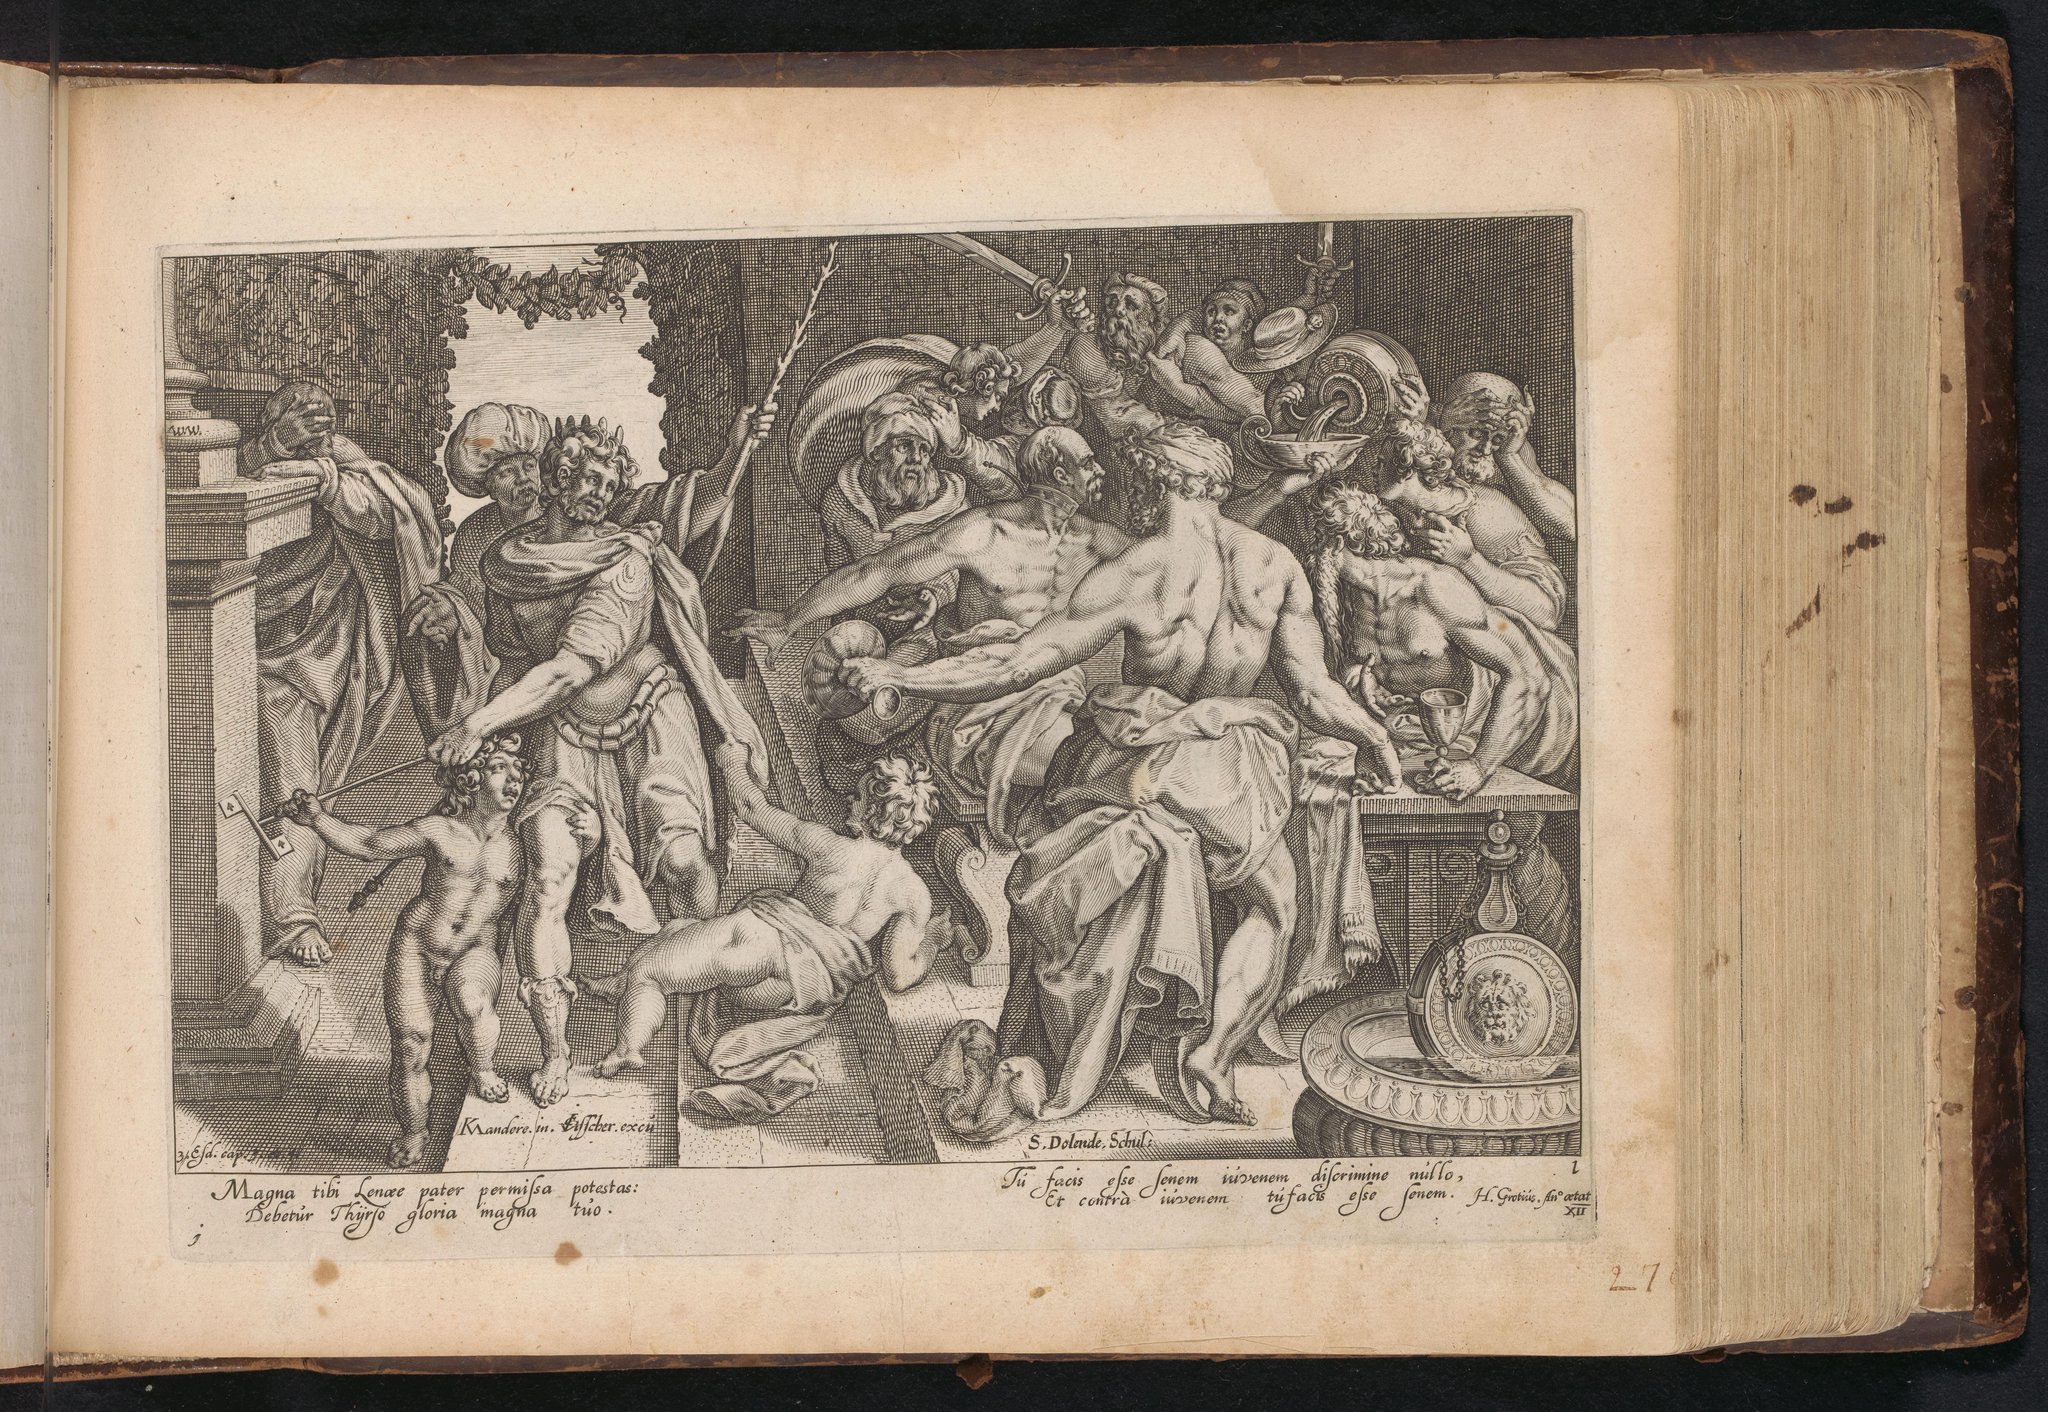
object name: album leaf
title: Scènes uit het apocriefe Bijbelboek 3 Esdras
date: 1595-1596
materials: paper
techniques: engraving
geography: amsterdam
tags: the books of ezra, nehemiah, and esdras, wine ~ alcoholic drinks, king, the first guardsman says (writes) that wine is the strongest of all things ~ contest of the three guardsmen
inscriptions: number: ‘27[6]’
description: De wijn als heerser over de wereld. Rond een tafel drinken mannen wijn. Ook een koning, links, staat onder invloed van wijn. Rondom hem dronken figuren. Linksonder een verwijzing naar de tekst in 3 Esdras 3-4. Onder de voorstelling verzen in het Latijn. Deze prent maakt deel uit van een album.